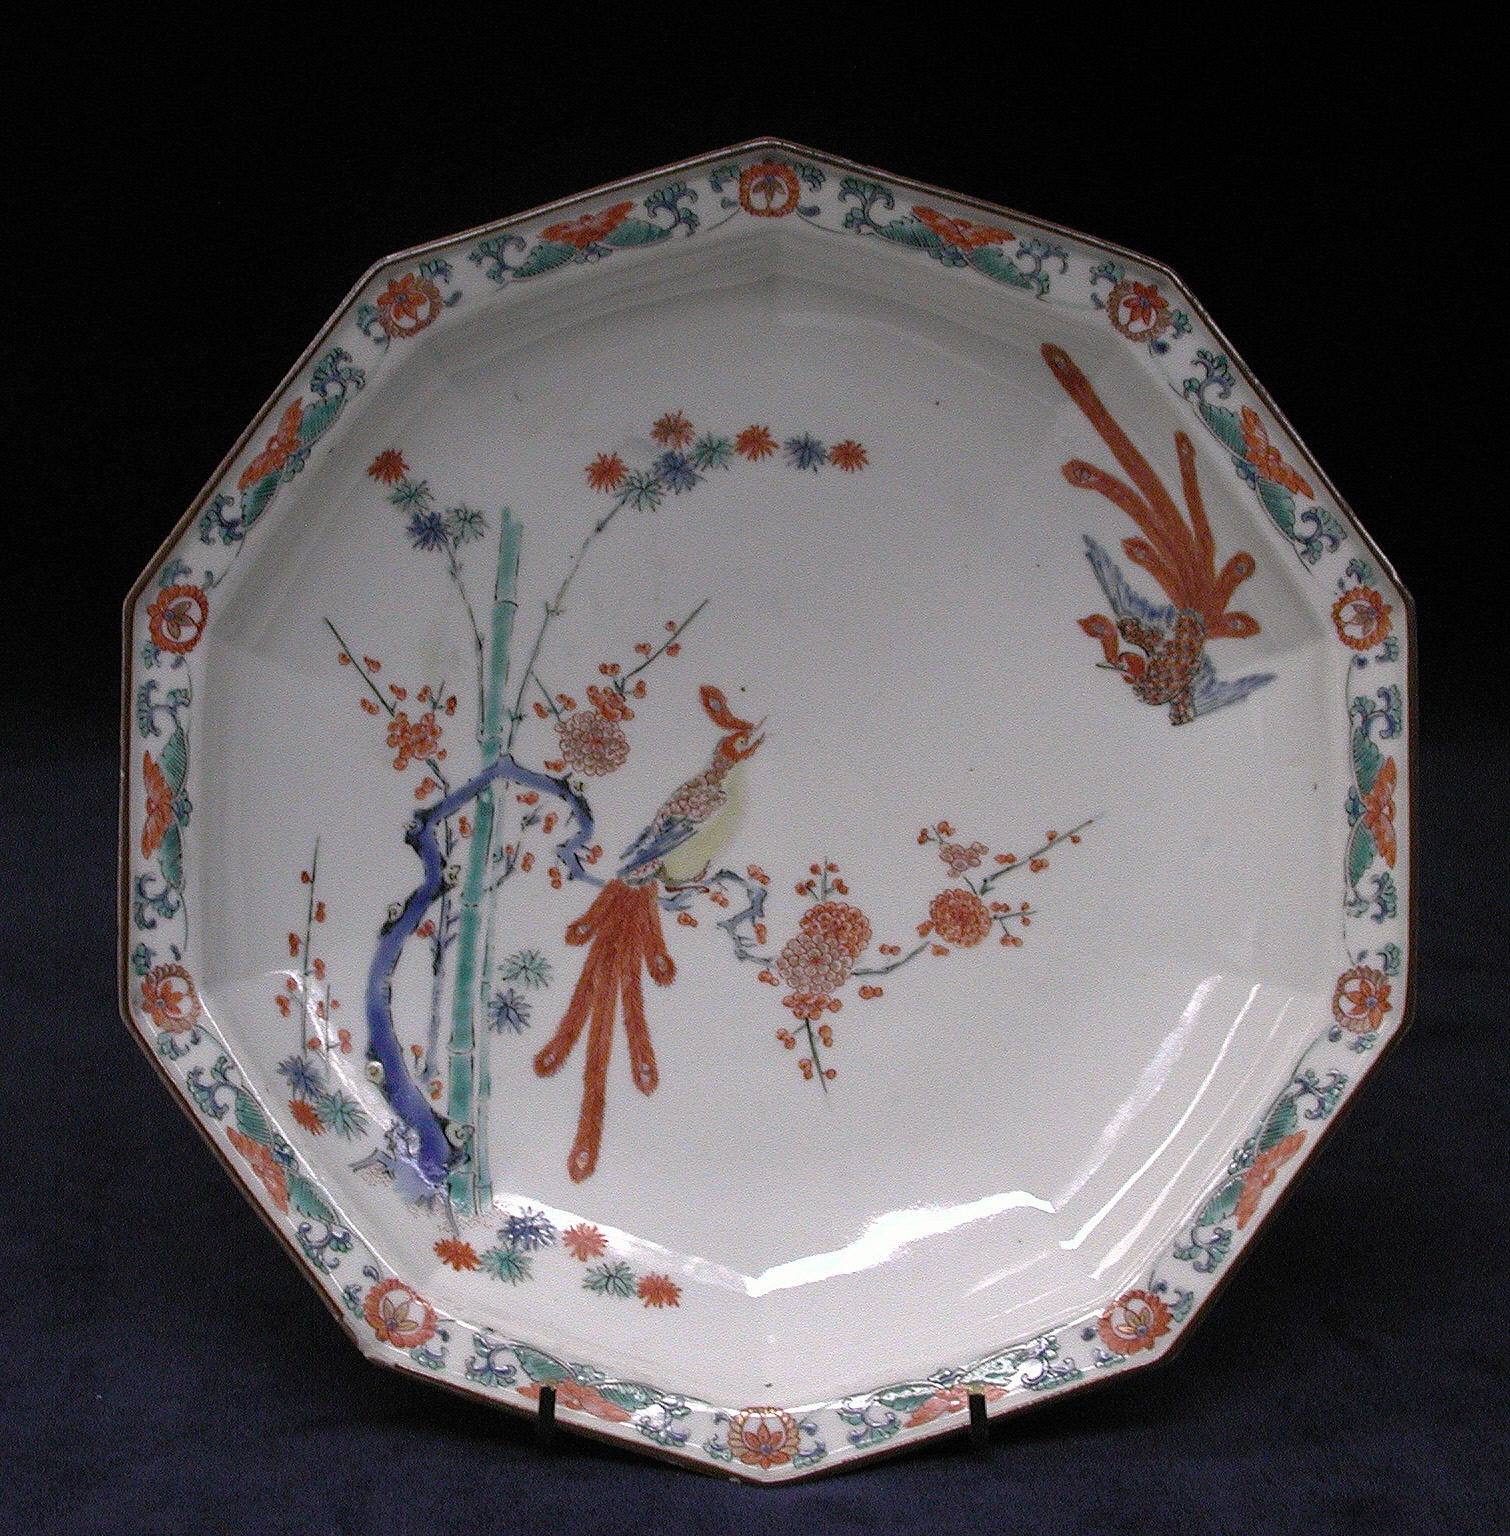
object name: plate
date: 1690-1700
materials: hard paste porcelain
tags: birds,flowers